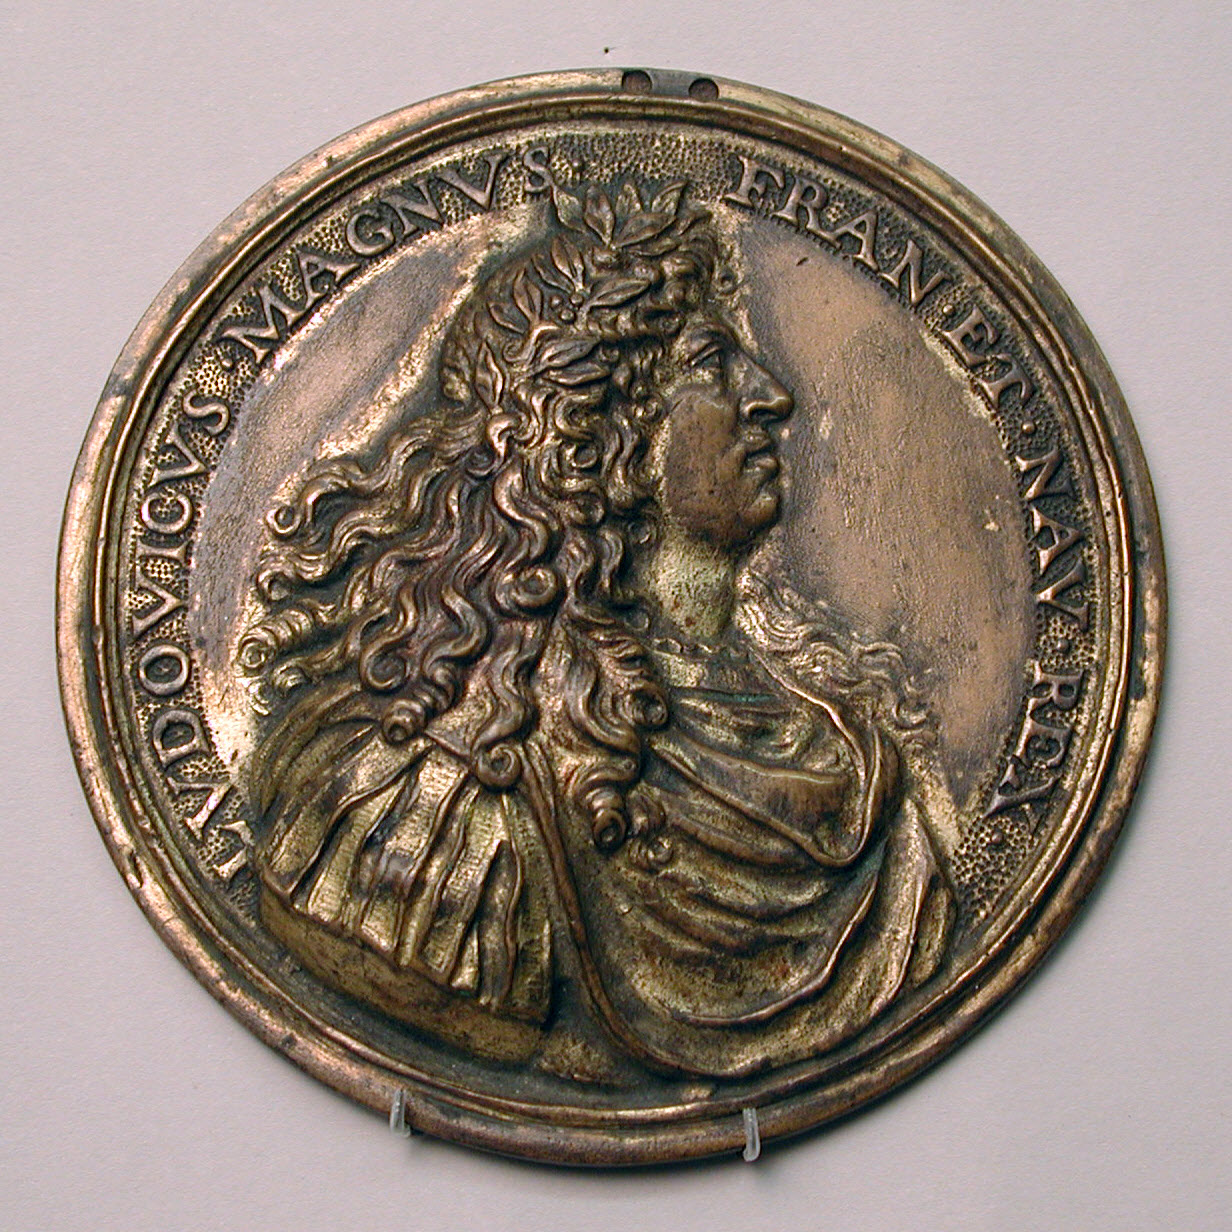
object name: medal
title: Louis XIV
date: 1675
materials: bronze, gilt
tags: louis xiv,profiles